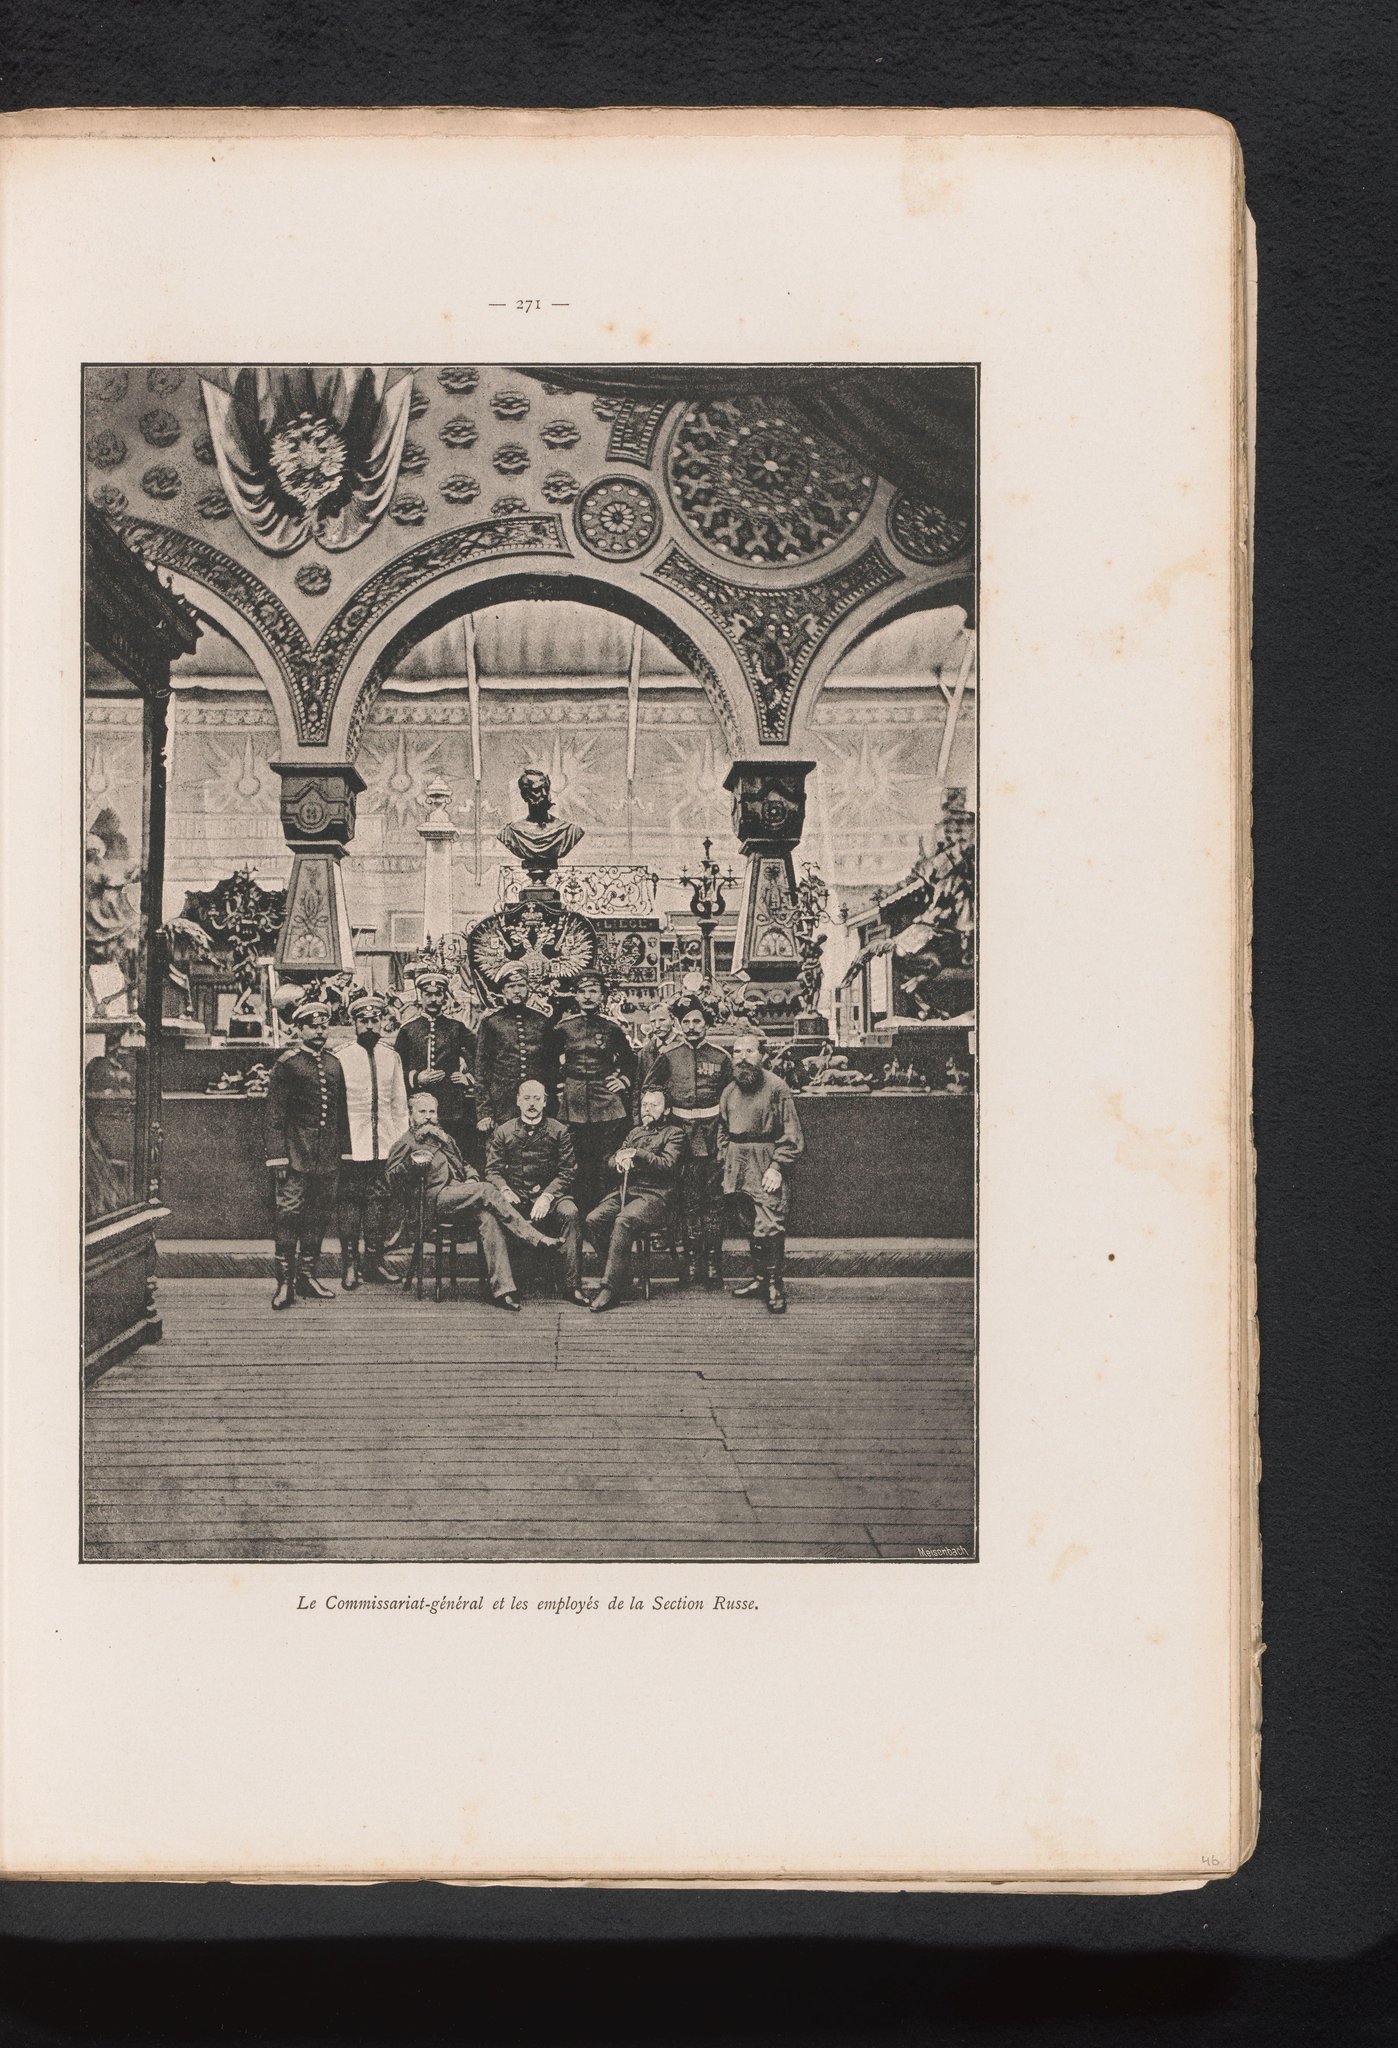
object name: photomechanical print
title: Groepsportret van de commissie en werknemers van het Russische deel van de Wereldtentoonstelling van 1885 in Antwerpen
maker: Anonymous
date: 1880-1885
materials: paper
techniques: autotype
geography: antwerp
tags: world fair, world exhibition, anonymous historical persons portrayed in a group, in a group-portrait, antwerp